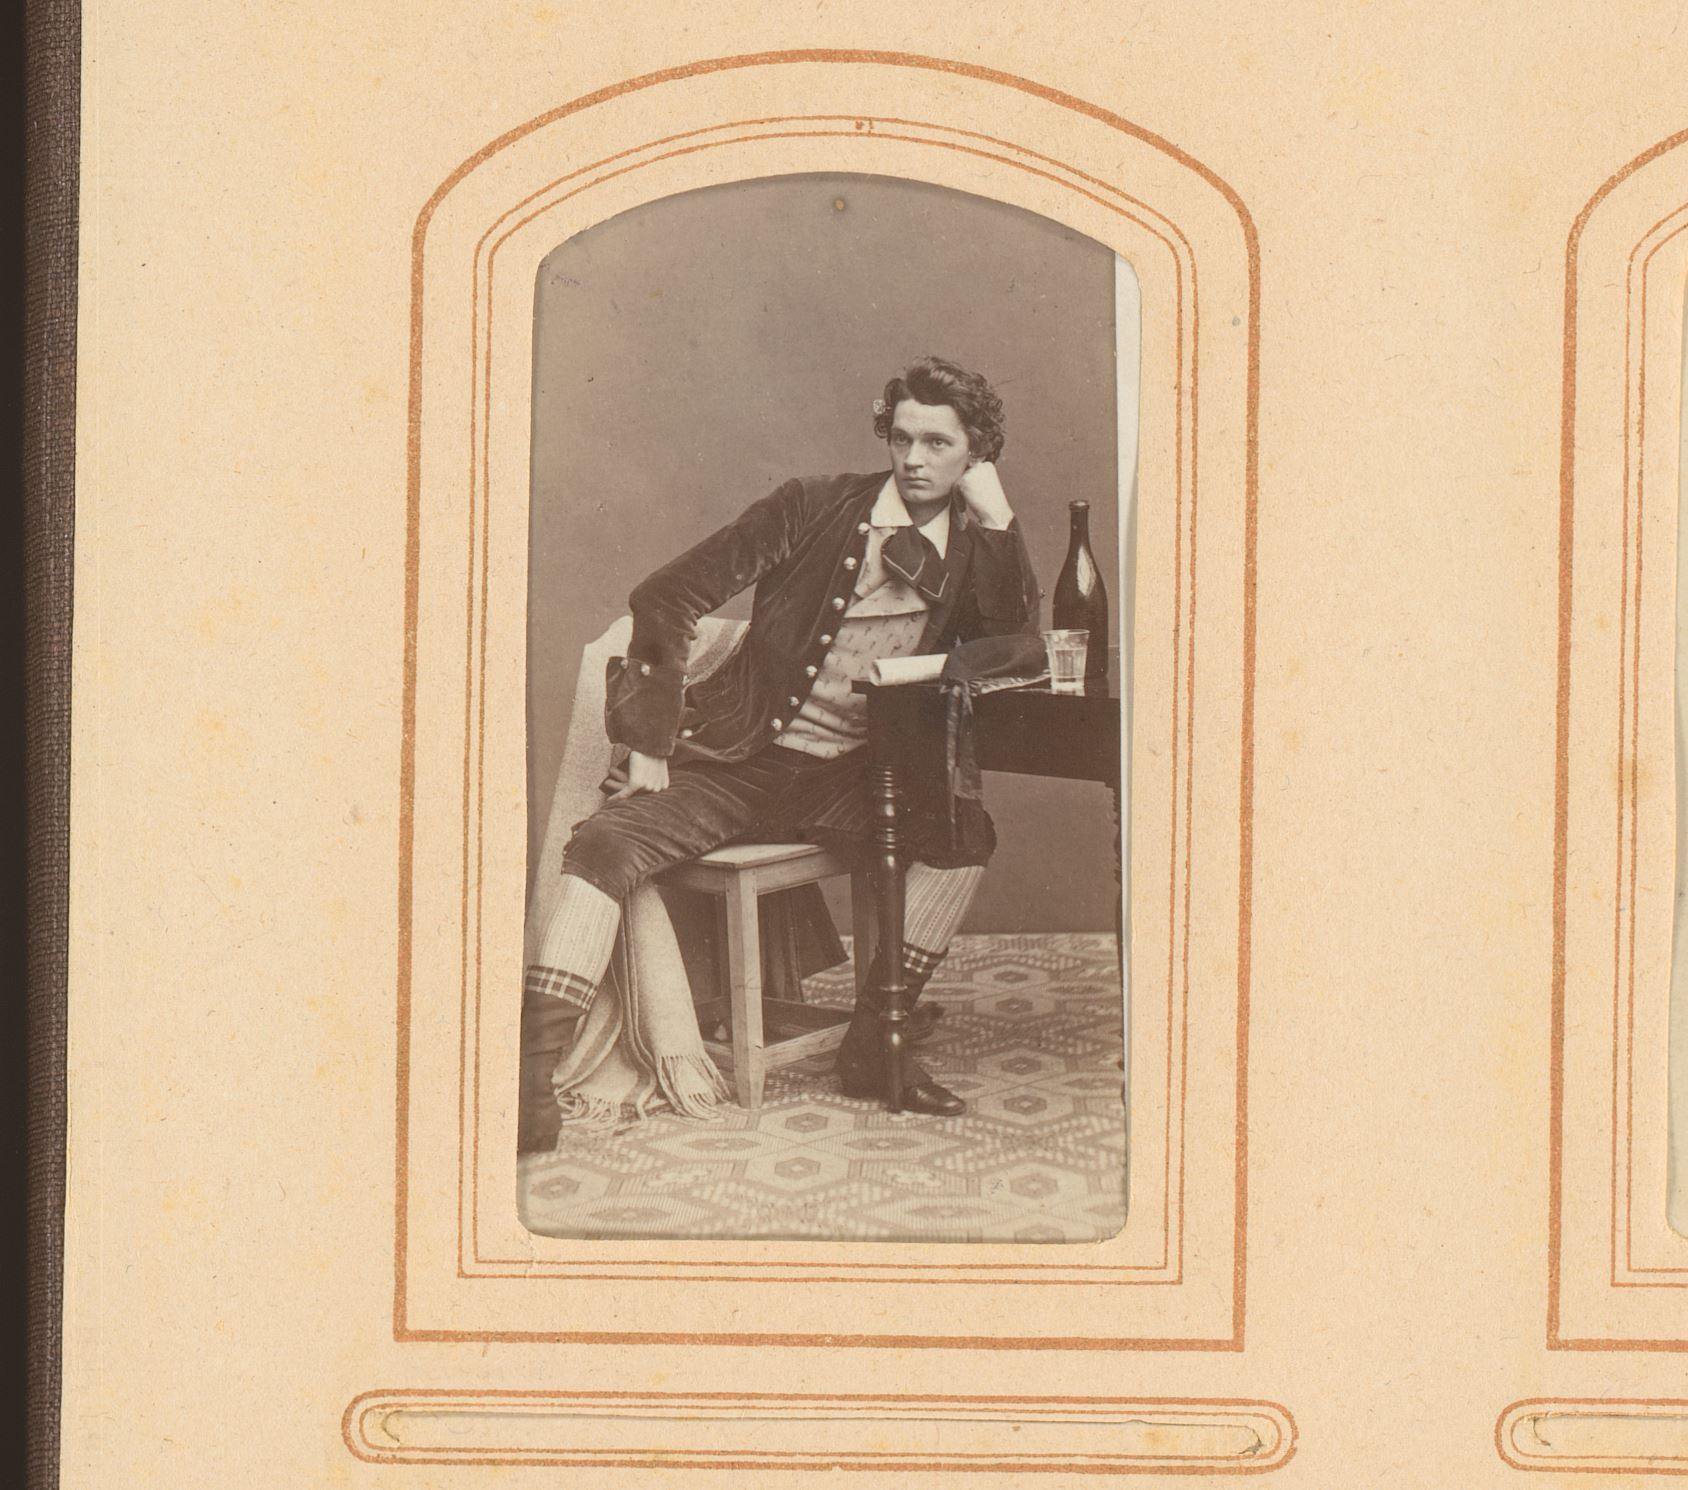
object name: album leaf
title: Portret van Axel Eemlund, zittend aan tafel met glas en fles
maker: johannes jaeger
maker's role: fotograaf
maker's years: 1832-1908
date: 1855-1890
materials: cardboard, photographic support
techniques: albumen print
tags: sitting figure, historical persons, portrait of actor, actress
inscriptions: inscription: ‘J. Jaeger/ Fotograf/ Regeringsgatan No. 11/ hörnet af Herkulesbacke/ Stockholm’, annotation: ‘Axel Eemlund/ 1838-1901’